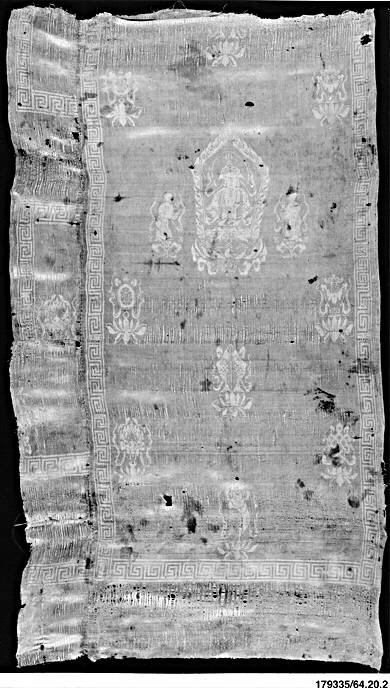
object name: thangka curtain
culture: chinese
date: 1601-1800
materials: silk